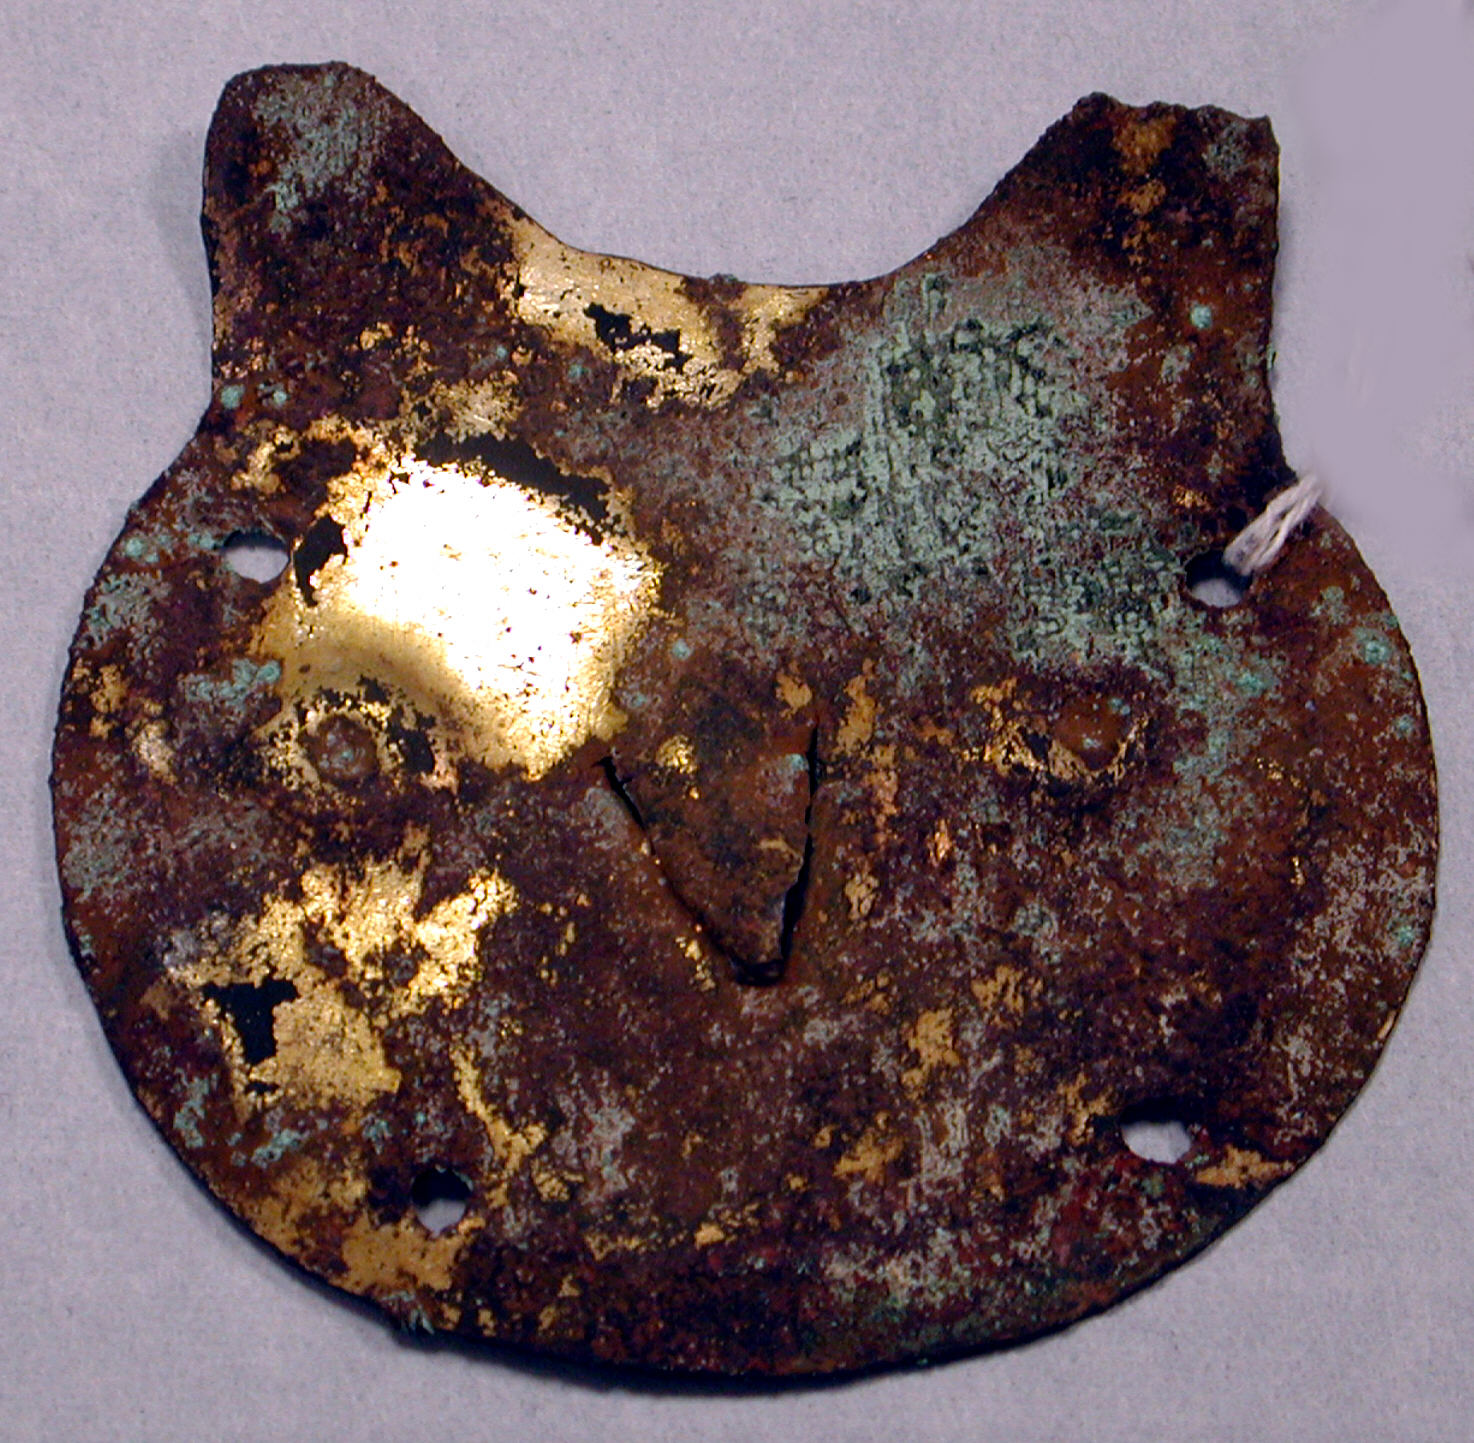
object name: plaque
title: Copper Animal Plaque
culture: vicús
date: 300 BCE-200 CE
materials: copper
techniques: hammering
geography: peru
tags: animals